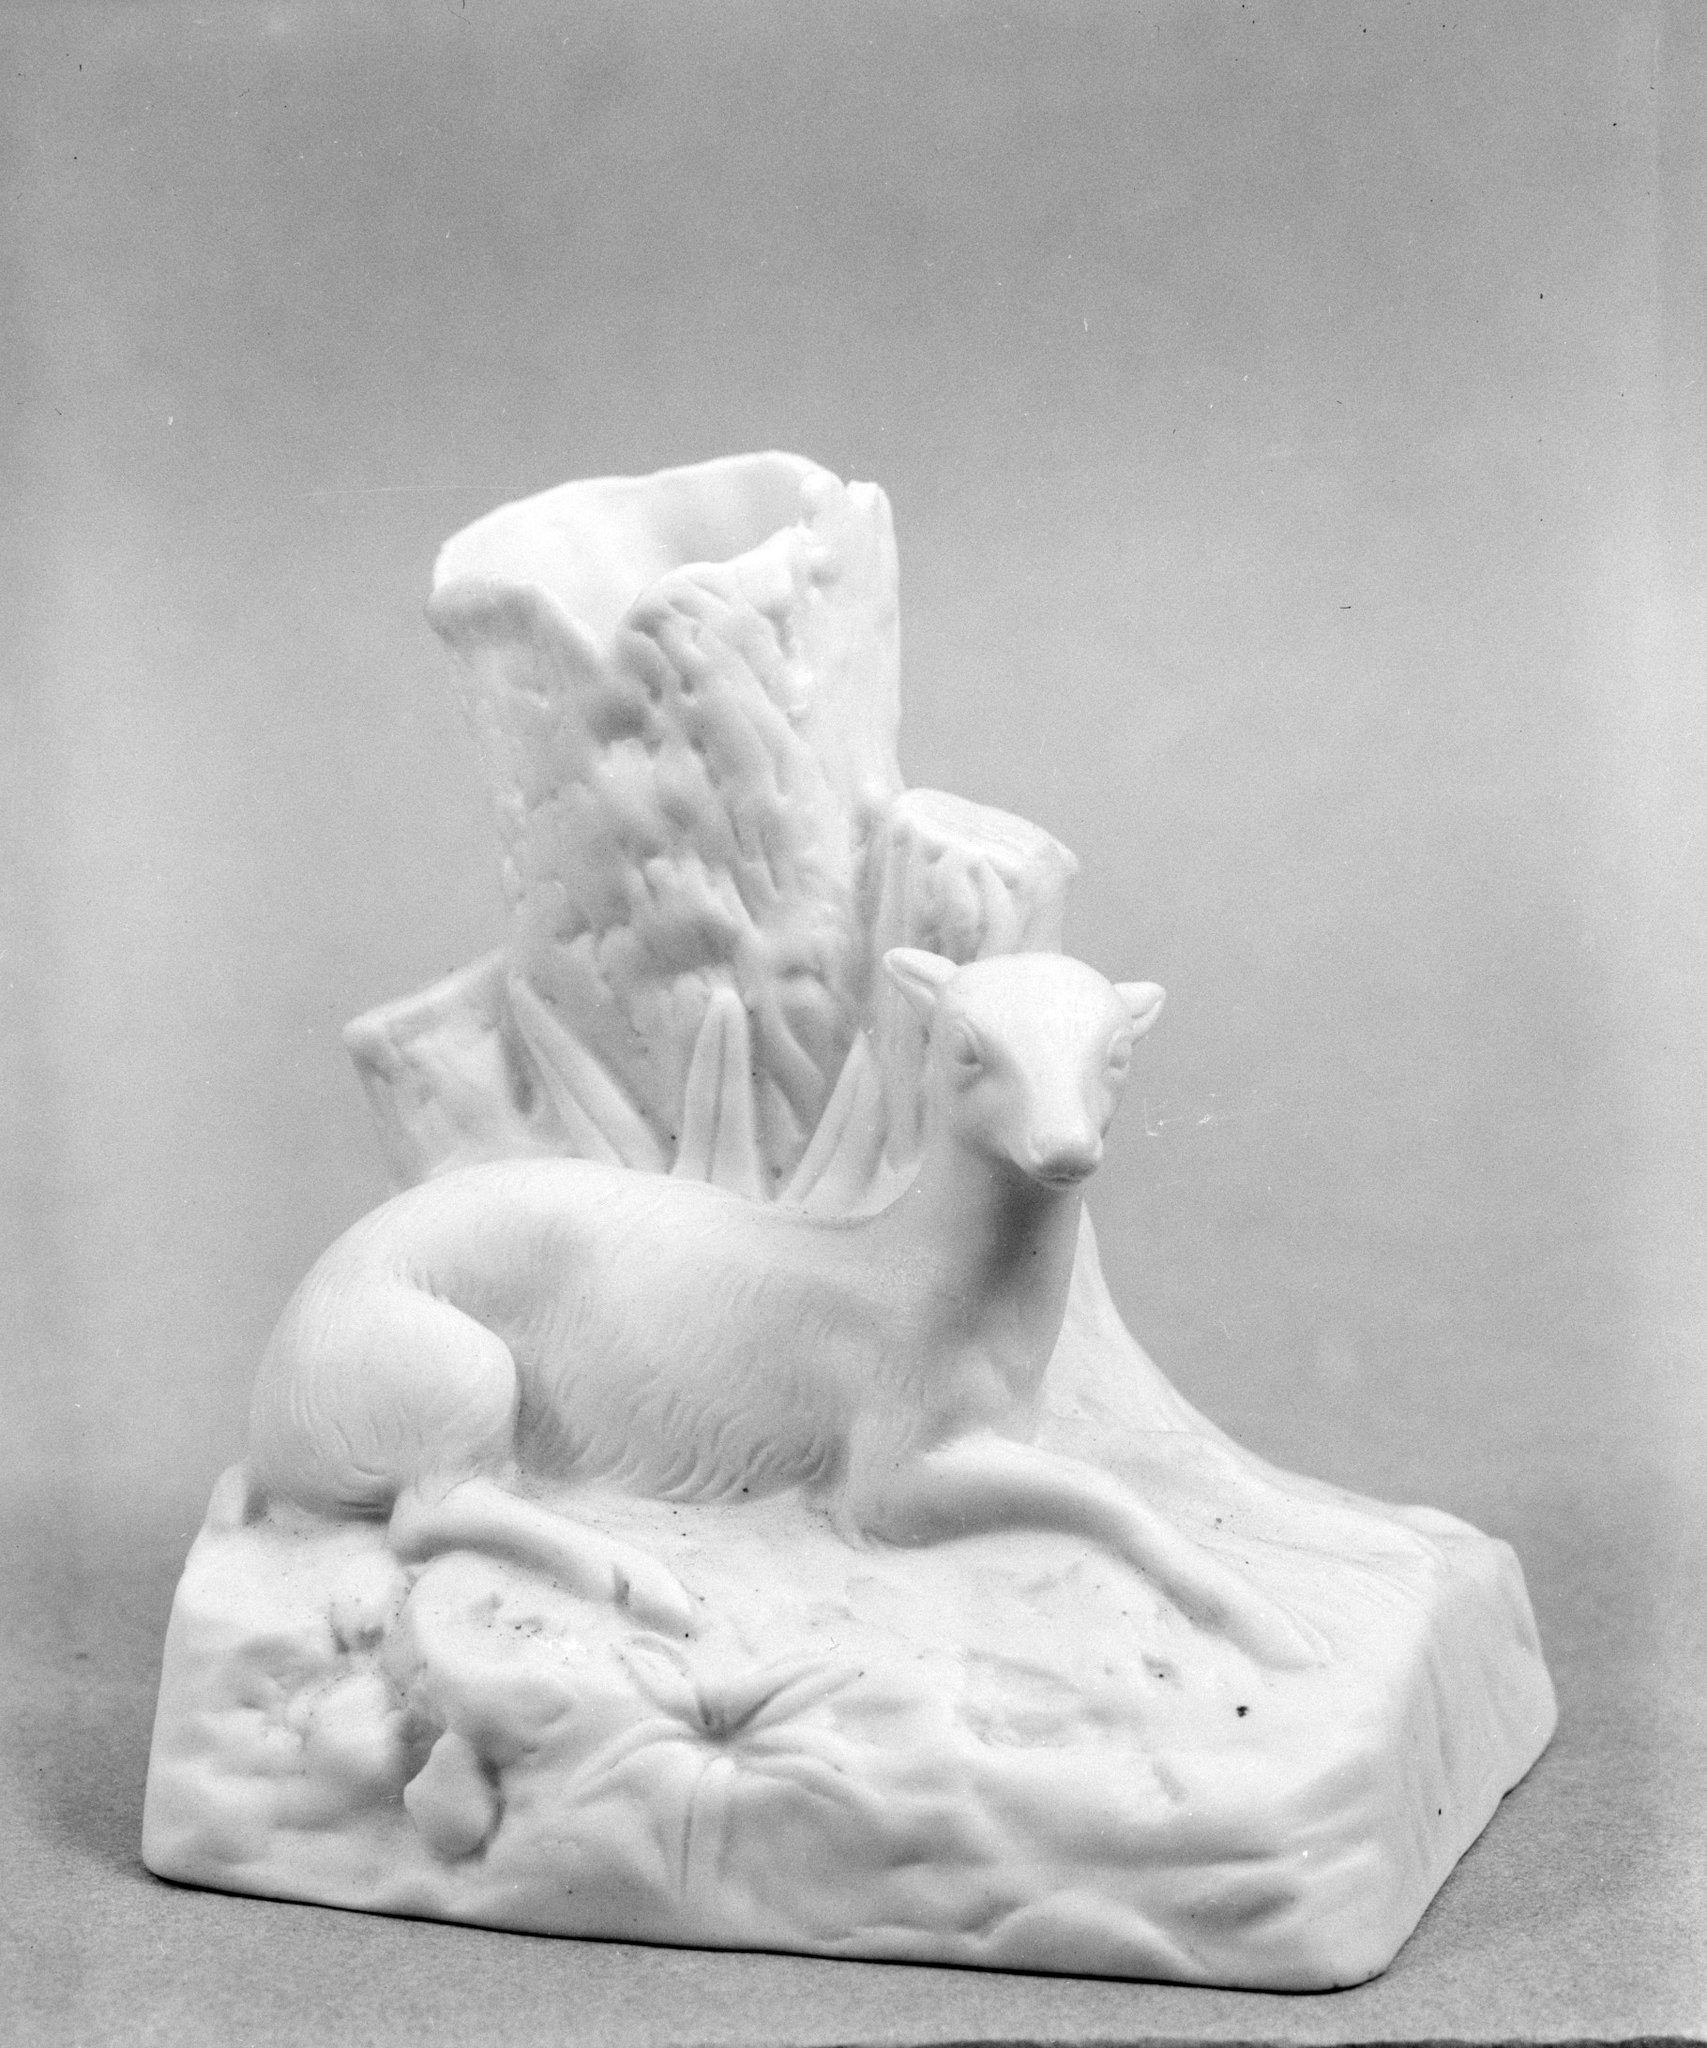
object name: matchsafe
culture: american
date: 1830-1870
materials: porcelain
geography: united states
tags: animals